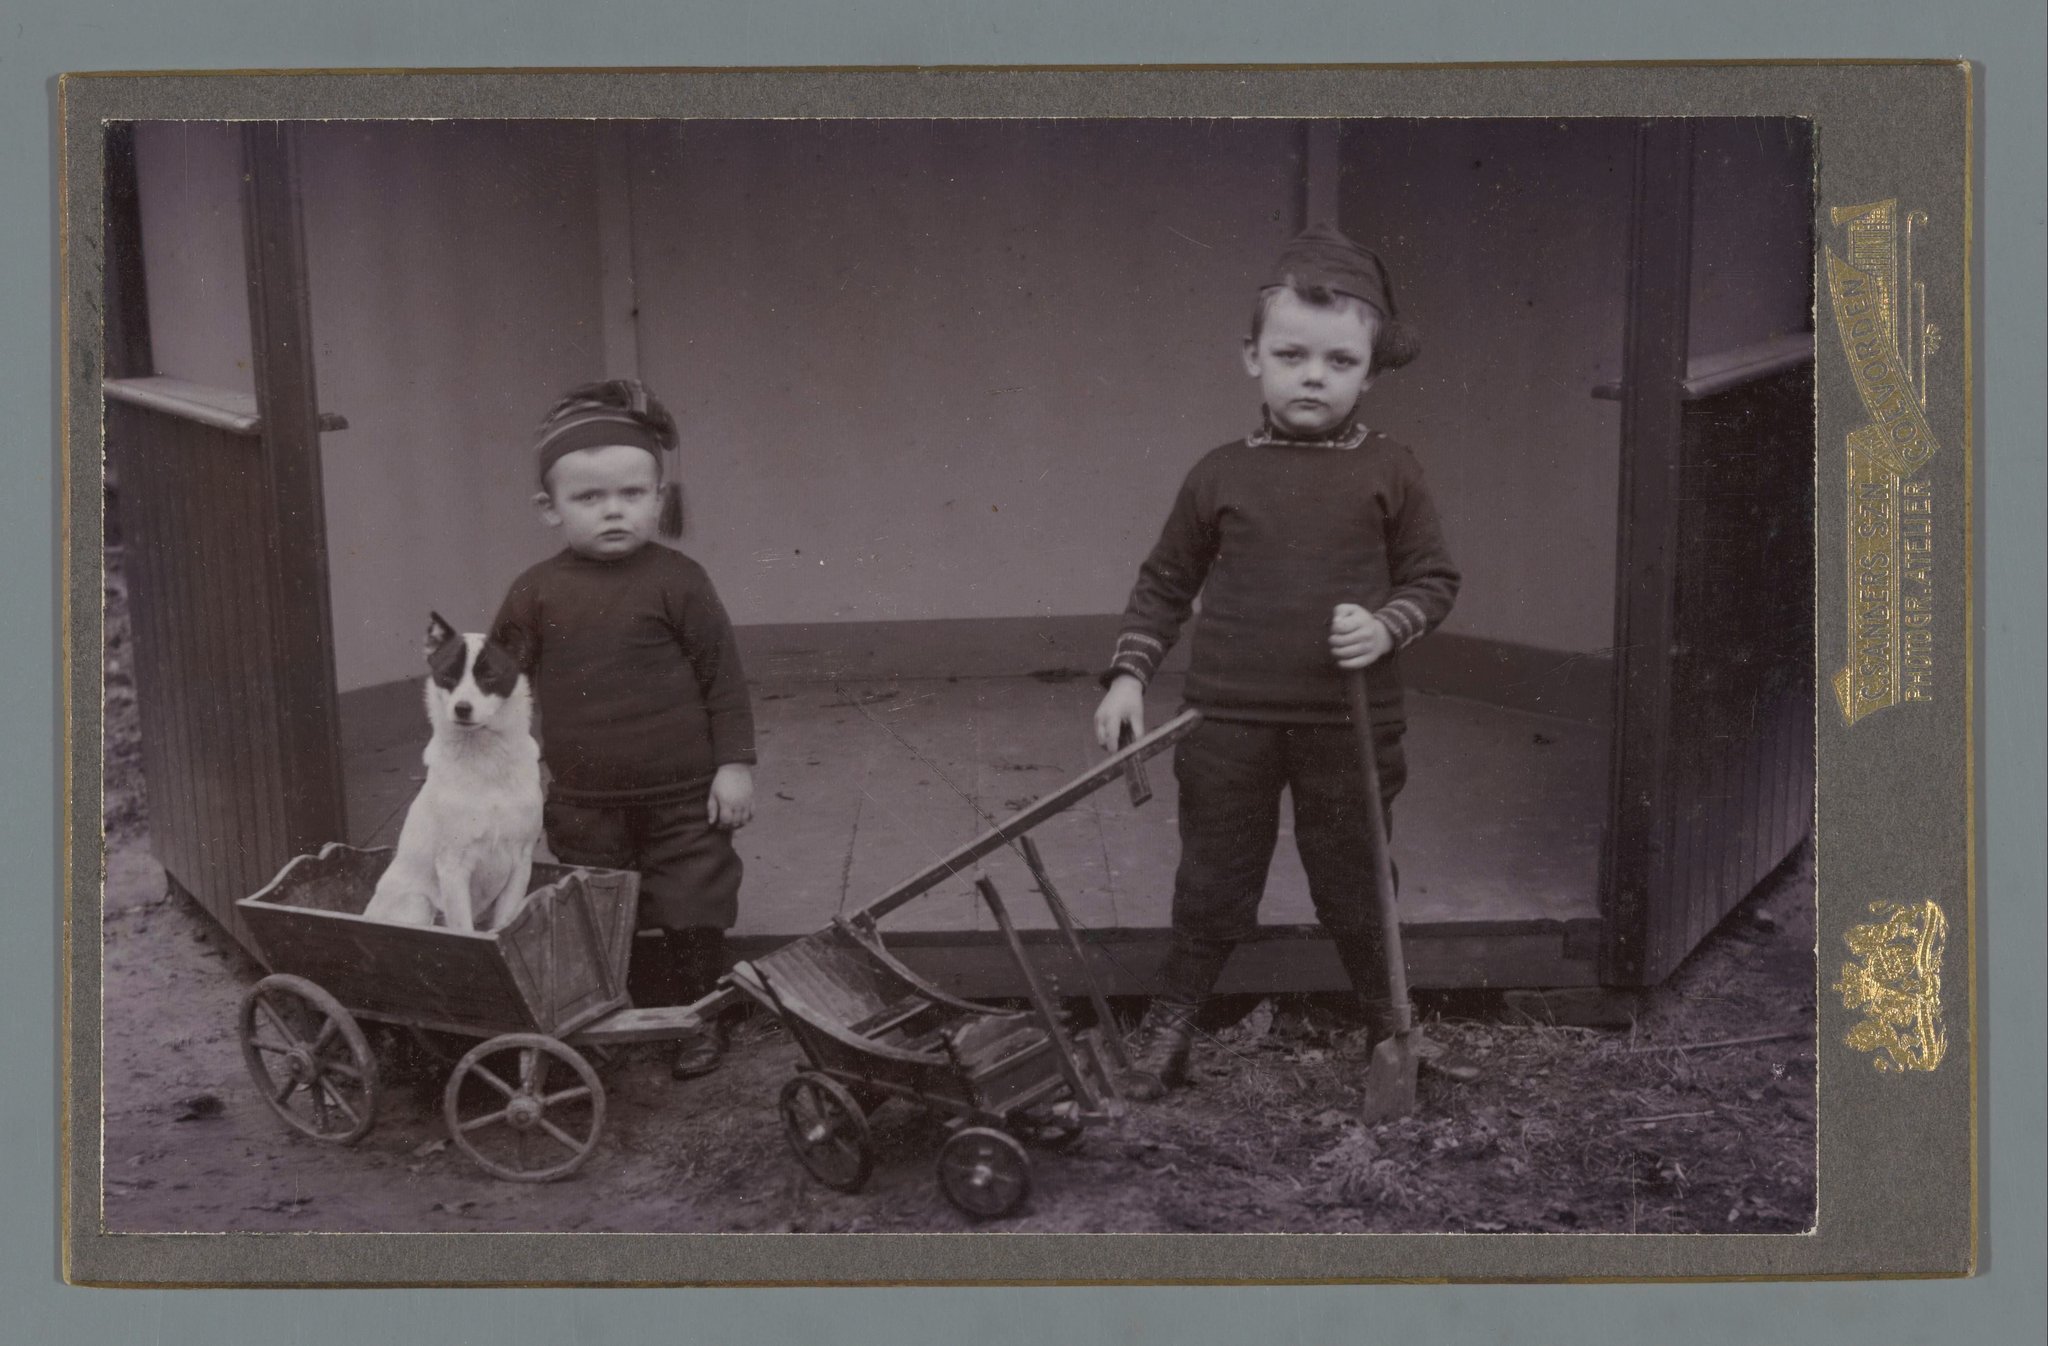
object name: photograph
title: Portret van twee jongens met gebreide mutsen op bij speelgoedkarren en een hond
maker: c. sanders szn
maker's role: fotograaf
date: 1900-1930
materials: cardboard, photographic support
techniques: collodion silver print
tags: knitting, (playing with) toys, dog, child (at home)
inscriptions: : ‘Photogr. Atelier, Coevorden’